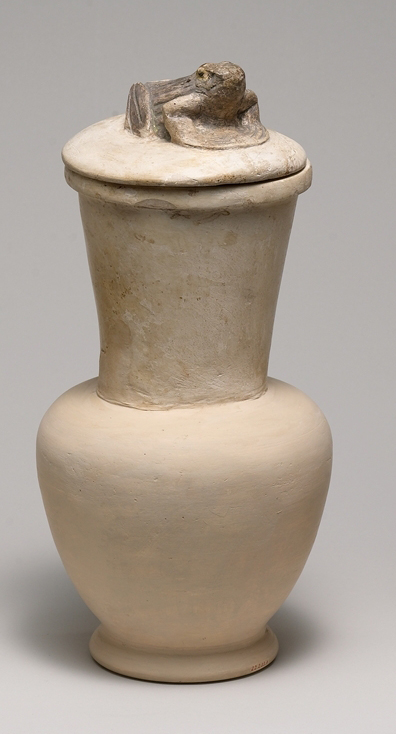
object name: jar and lid, frog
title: Jar and Lid Decorated with a Frog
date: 1390-1352 BCE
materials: limestone, paint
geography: egypt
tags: frogs